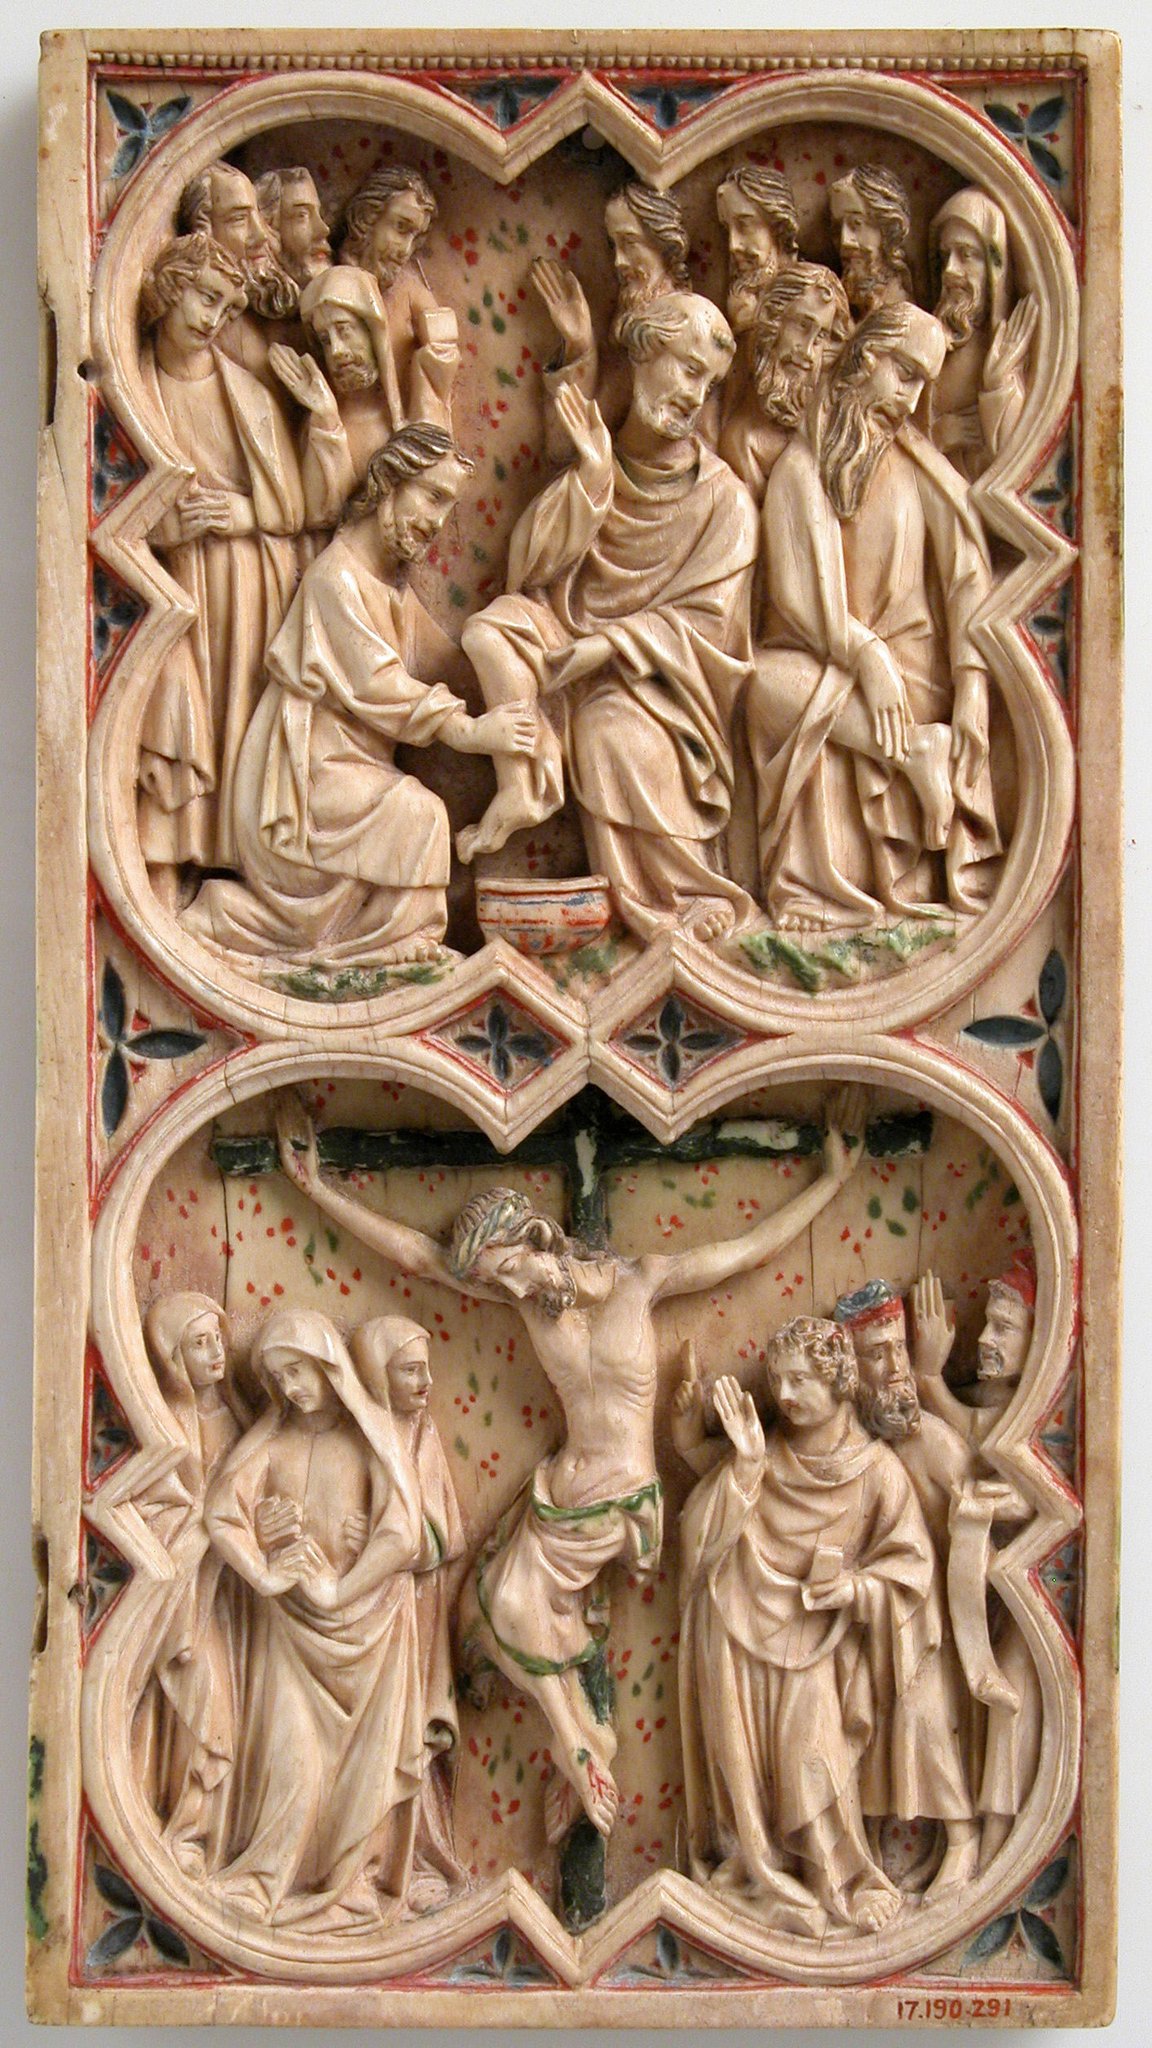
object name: diptych leaf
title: Painted Diptych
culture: french or spanish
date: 1340-1360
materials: ivory, paint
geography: france or north spain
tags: christ,virgin mary,crucifixion